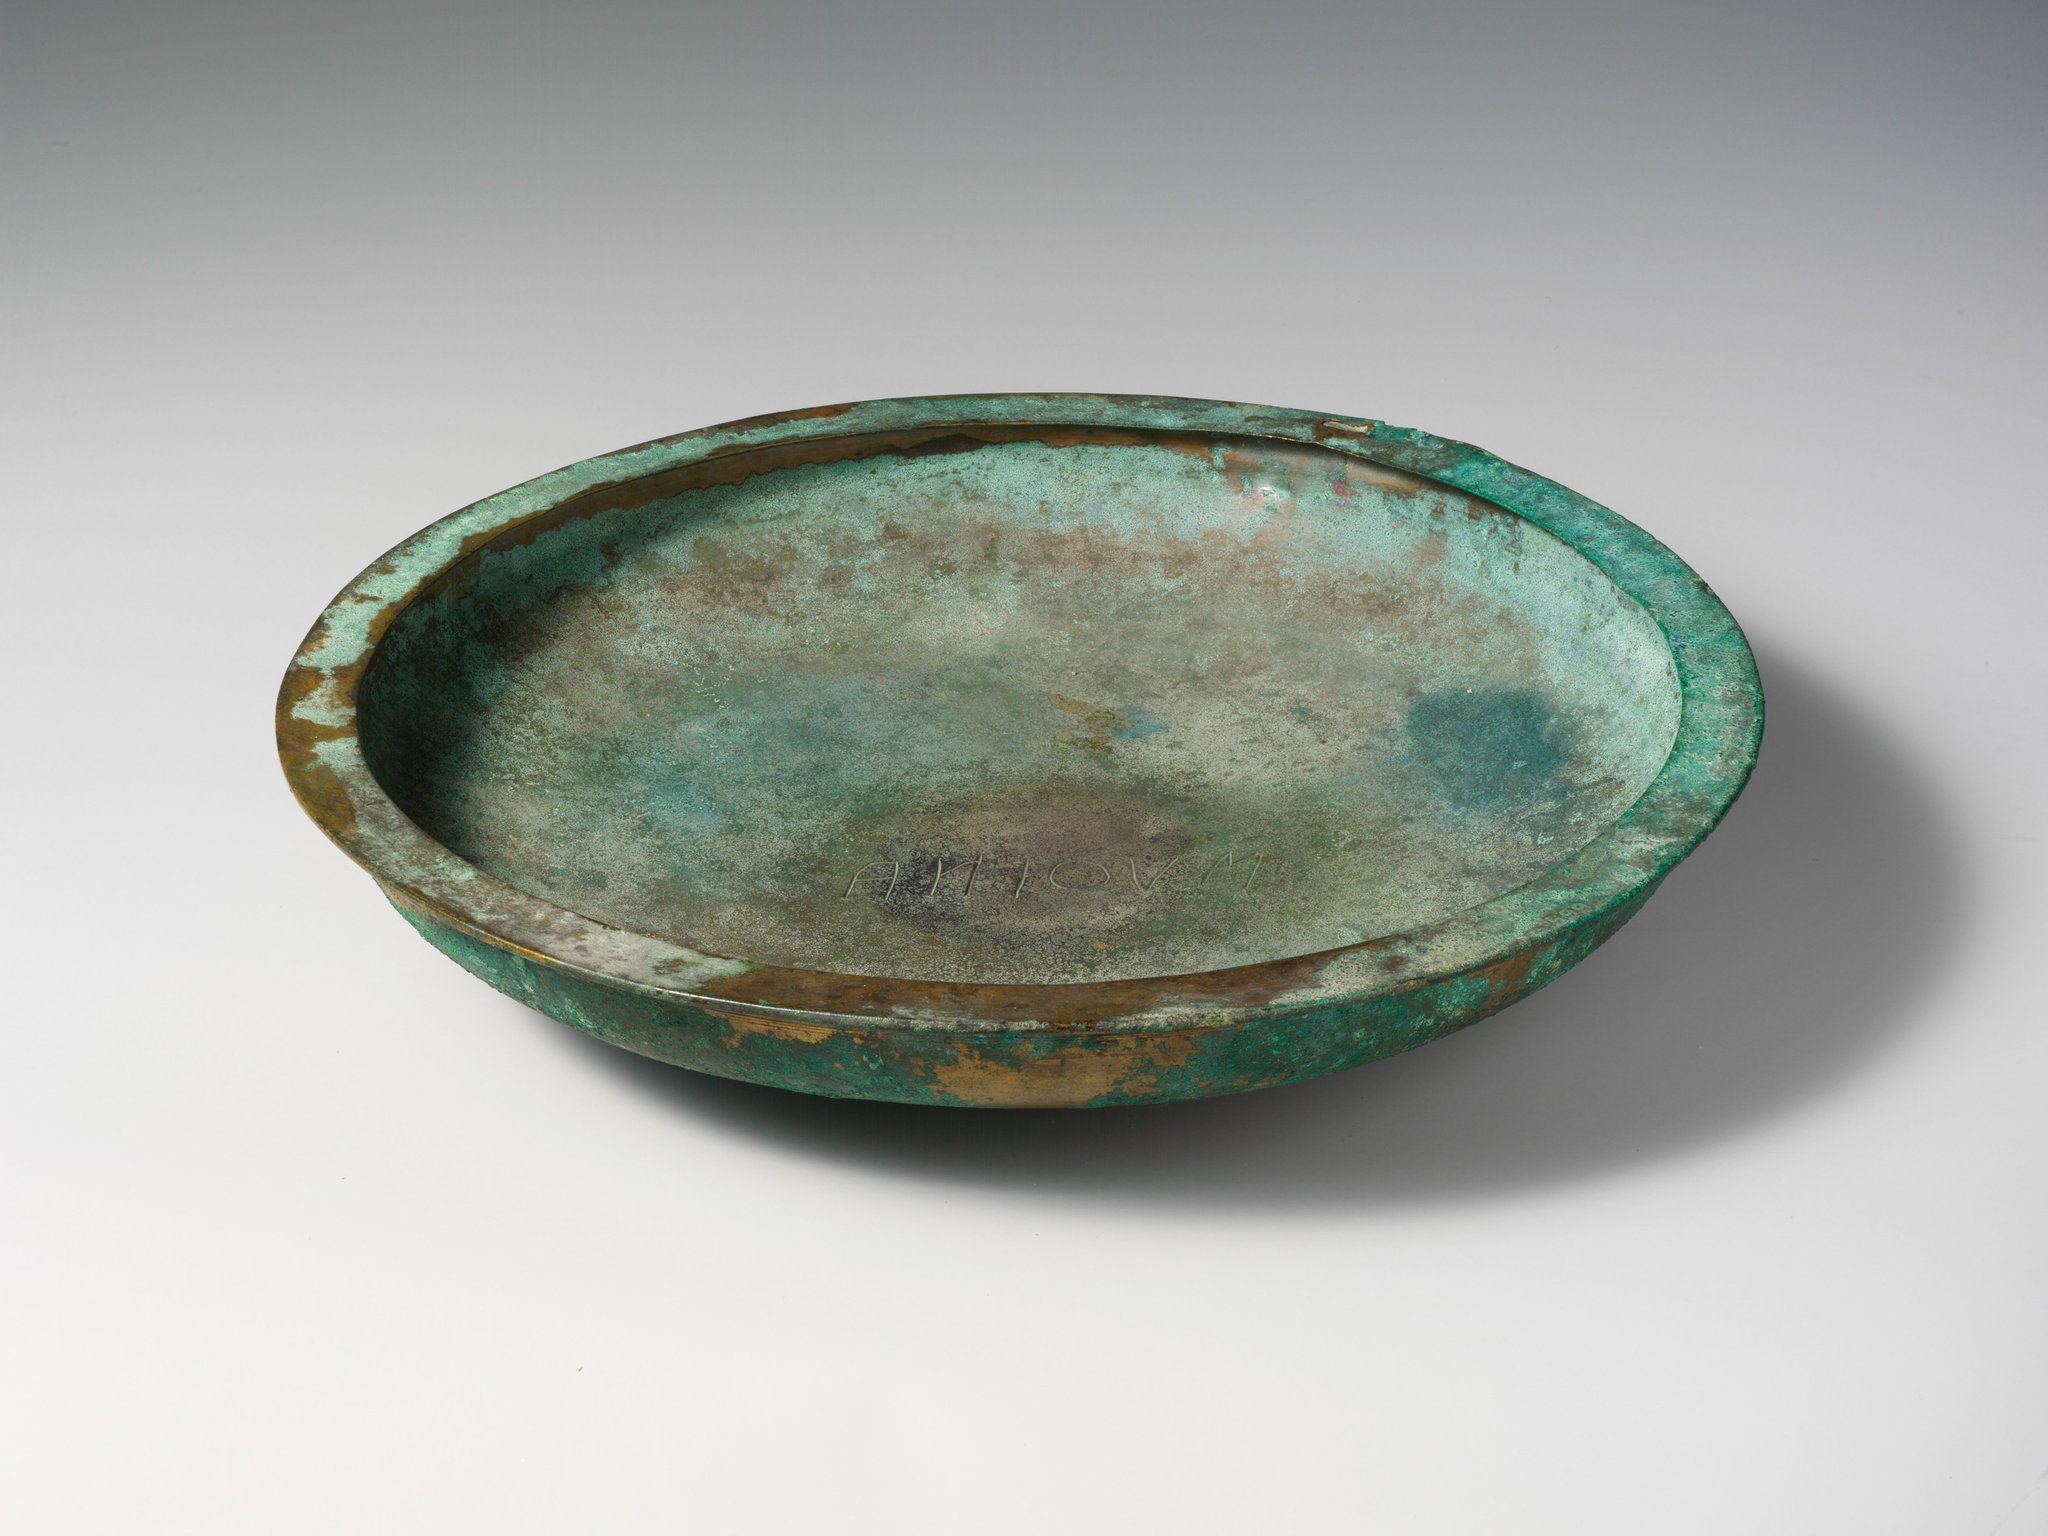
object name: patera, inscribed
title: Bronze patera (shallow bowl)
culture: etruscan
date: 334-301 BCE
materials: bronze